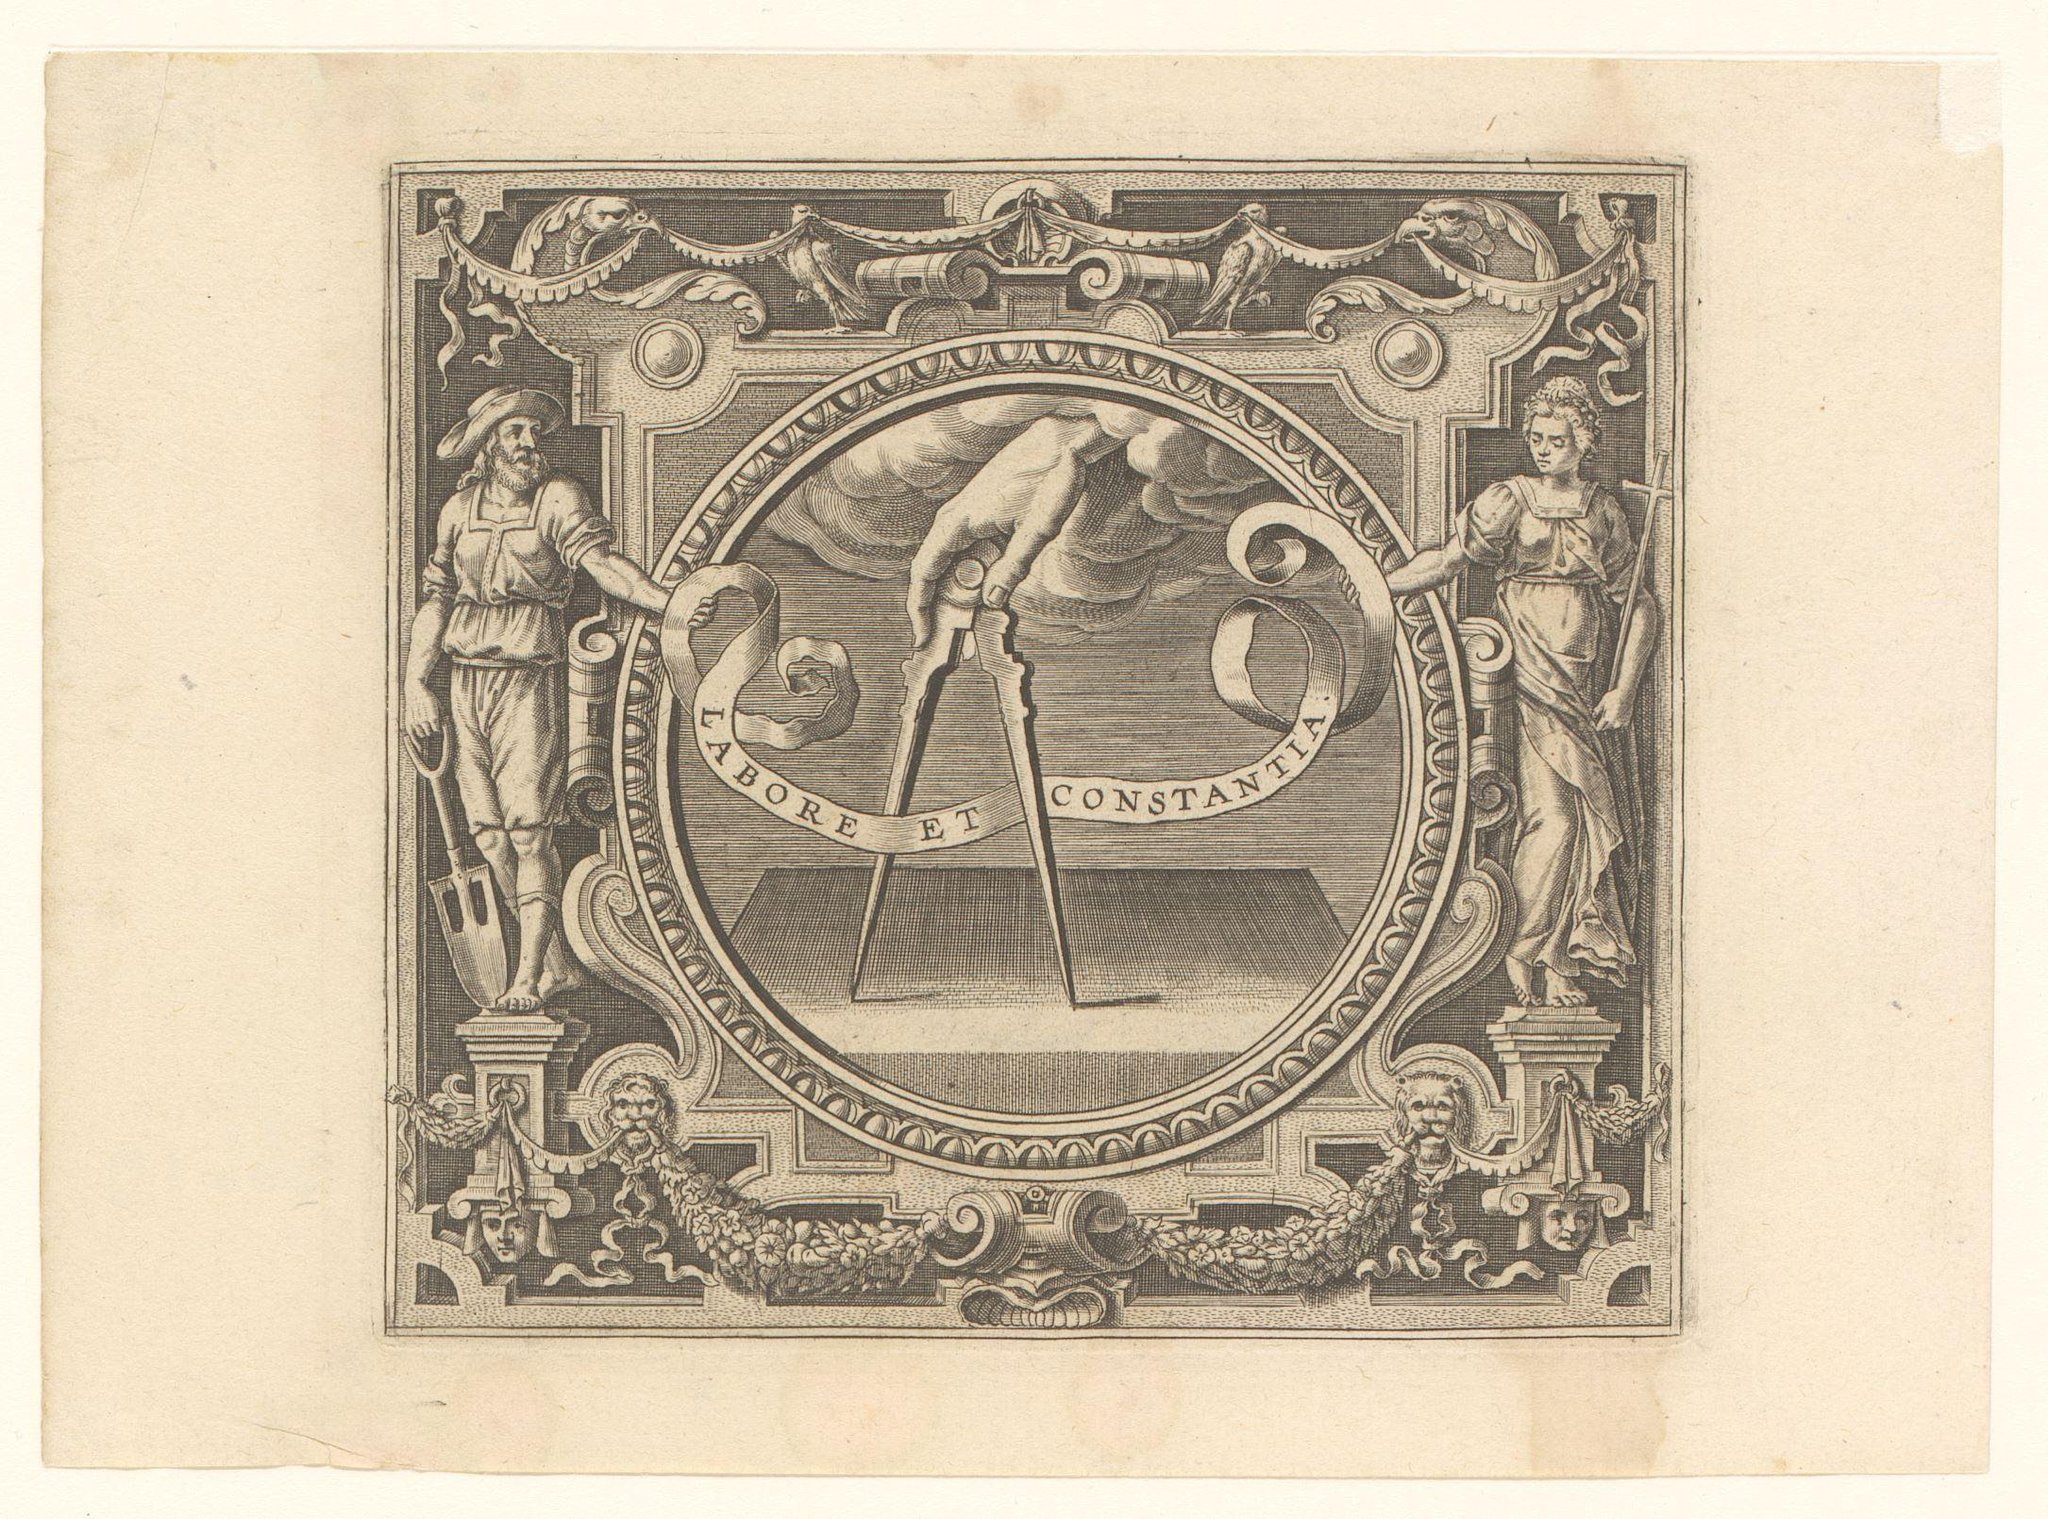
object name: printer's mark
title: Drukkersmerk van Plantijn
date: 1600-1670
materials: paper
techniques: engraving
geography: antwerp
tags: compasses, device (trade-mark of printer or publisher), constancy, tenacity; 'costanza', 'tenacità' (ripa), abstract ideas and concepts (+ personification)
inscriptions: collector's mark: Lugt 2228, collector's mark: Lugt 2760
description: Drukkersmerk voor de drukkerij Plantijn-Moretus in Antwerpen. In het midden een hand met een passer, een verwijzing naar het uithangbord van de drukkerij 'De gulden passer'. Op een banderol het motto van Christoffel Plantijn: Labore et constantia. Naast het motto staan een mannelijke en vrouwelijke personificatie met schep en crucifix.